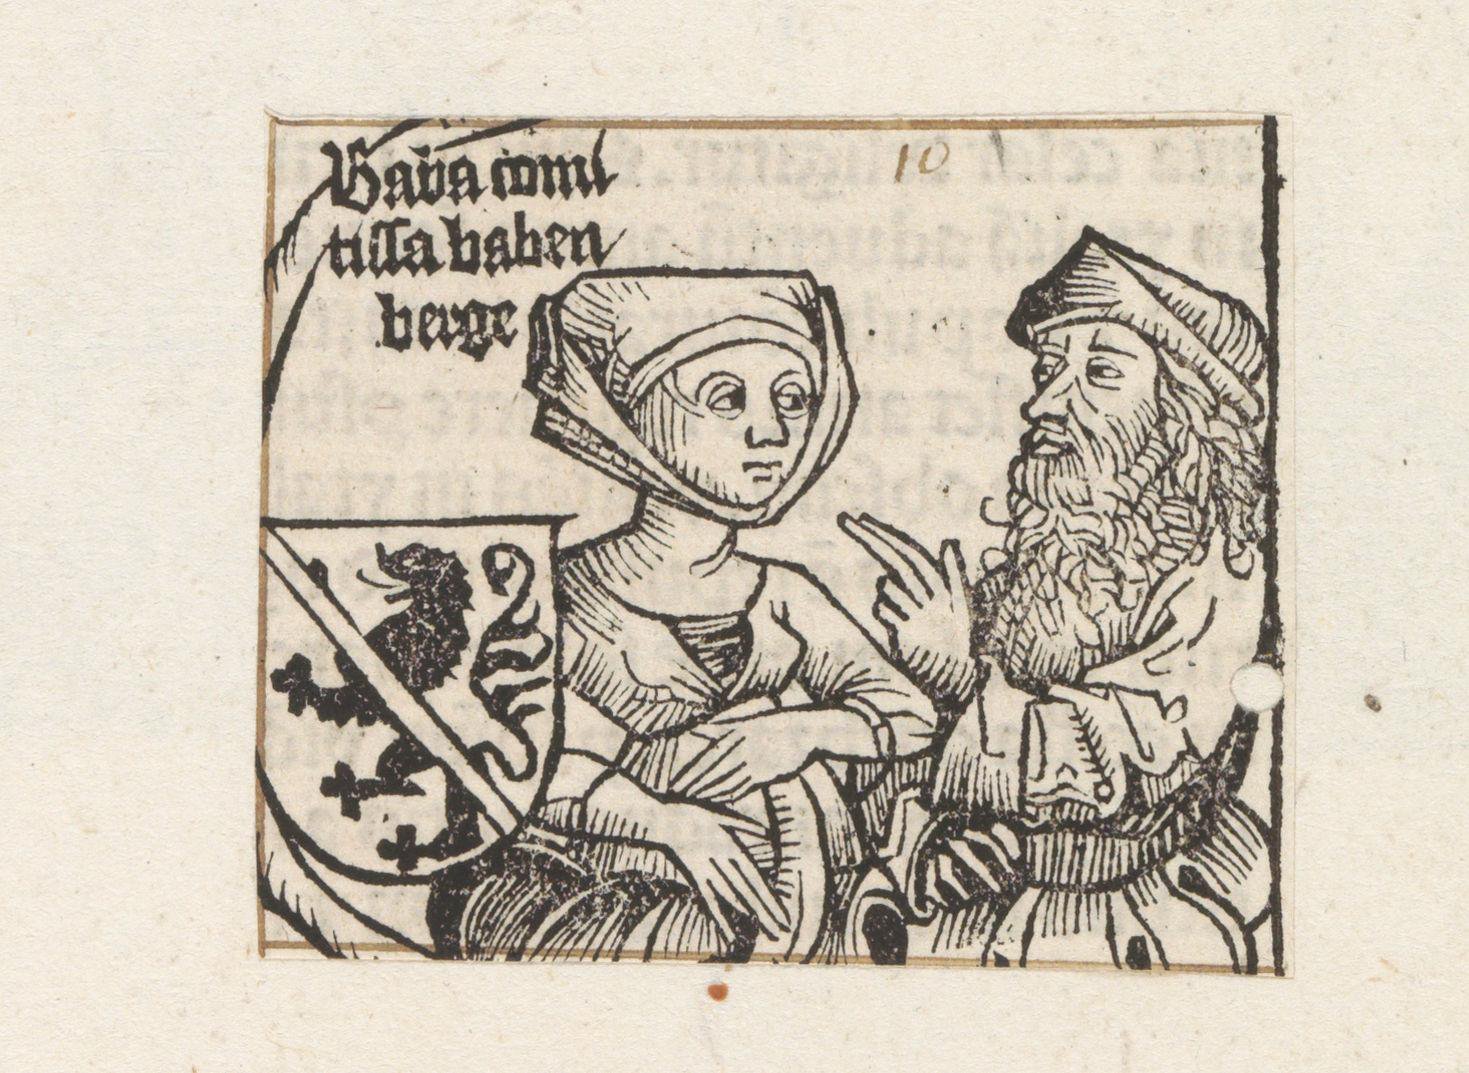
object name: album leaf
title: Liber Chronicarum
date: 1493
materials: paper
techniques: letterpress printing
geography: nuremberg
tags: armorial bearing, heraldry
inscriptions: inscription: ‘10’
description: Een bloemkelk met een man en vrouw. Daarbij een wapenschild. De voorstelling is onderdeel van de stamboom van keizer Hendrik II de Heilige in de Liber Chronicarum. De tekst en het schild identificeren de vrouw als ene Baba van Babenberg, dochter van Otto I van Saksen. De prent maakt deel uit van een album.